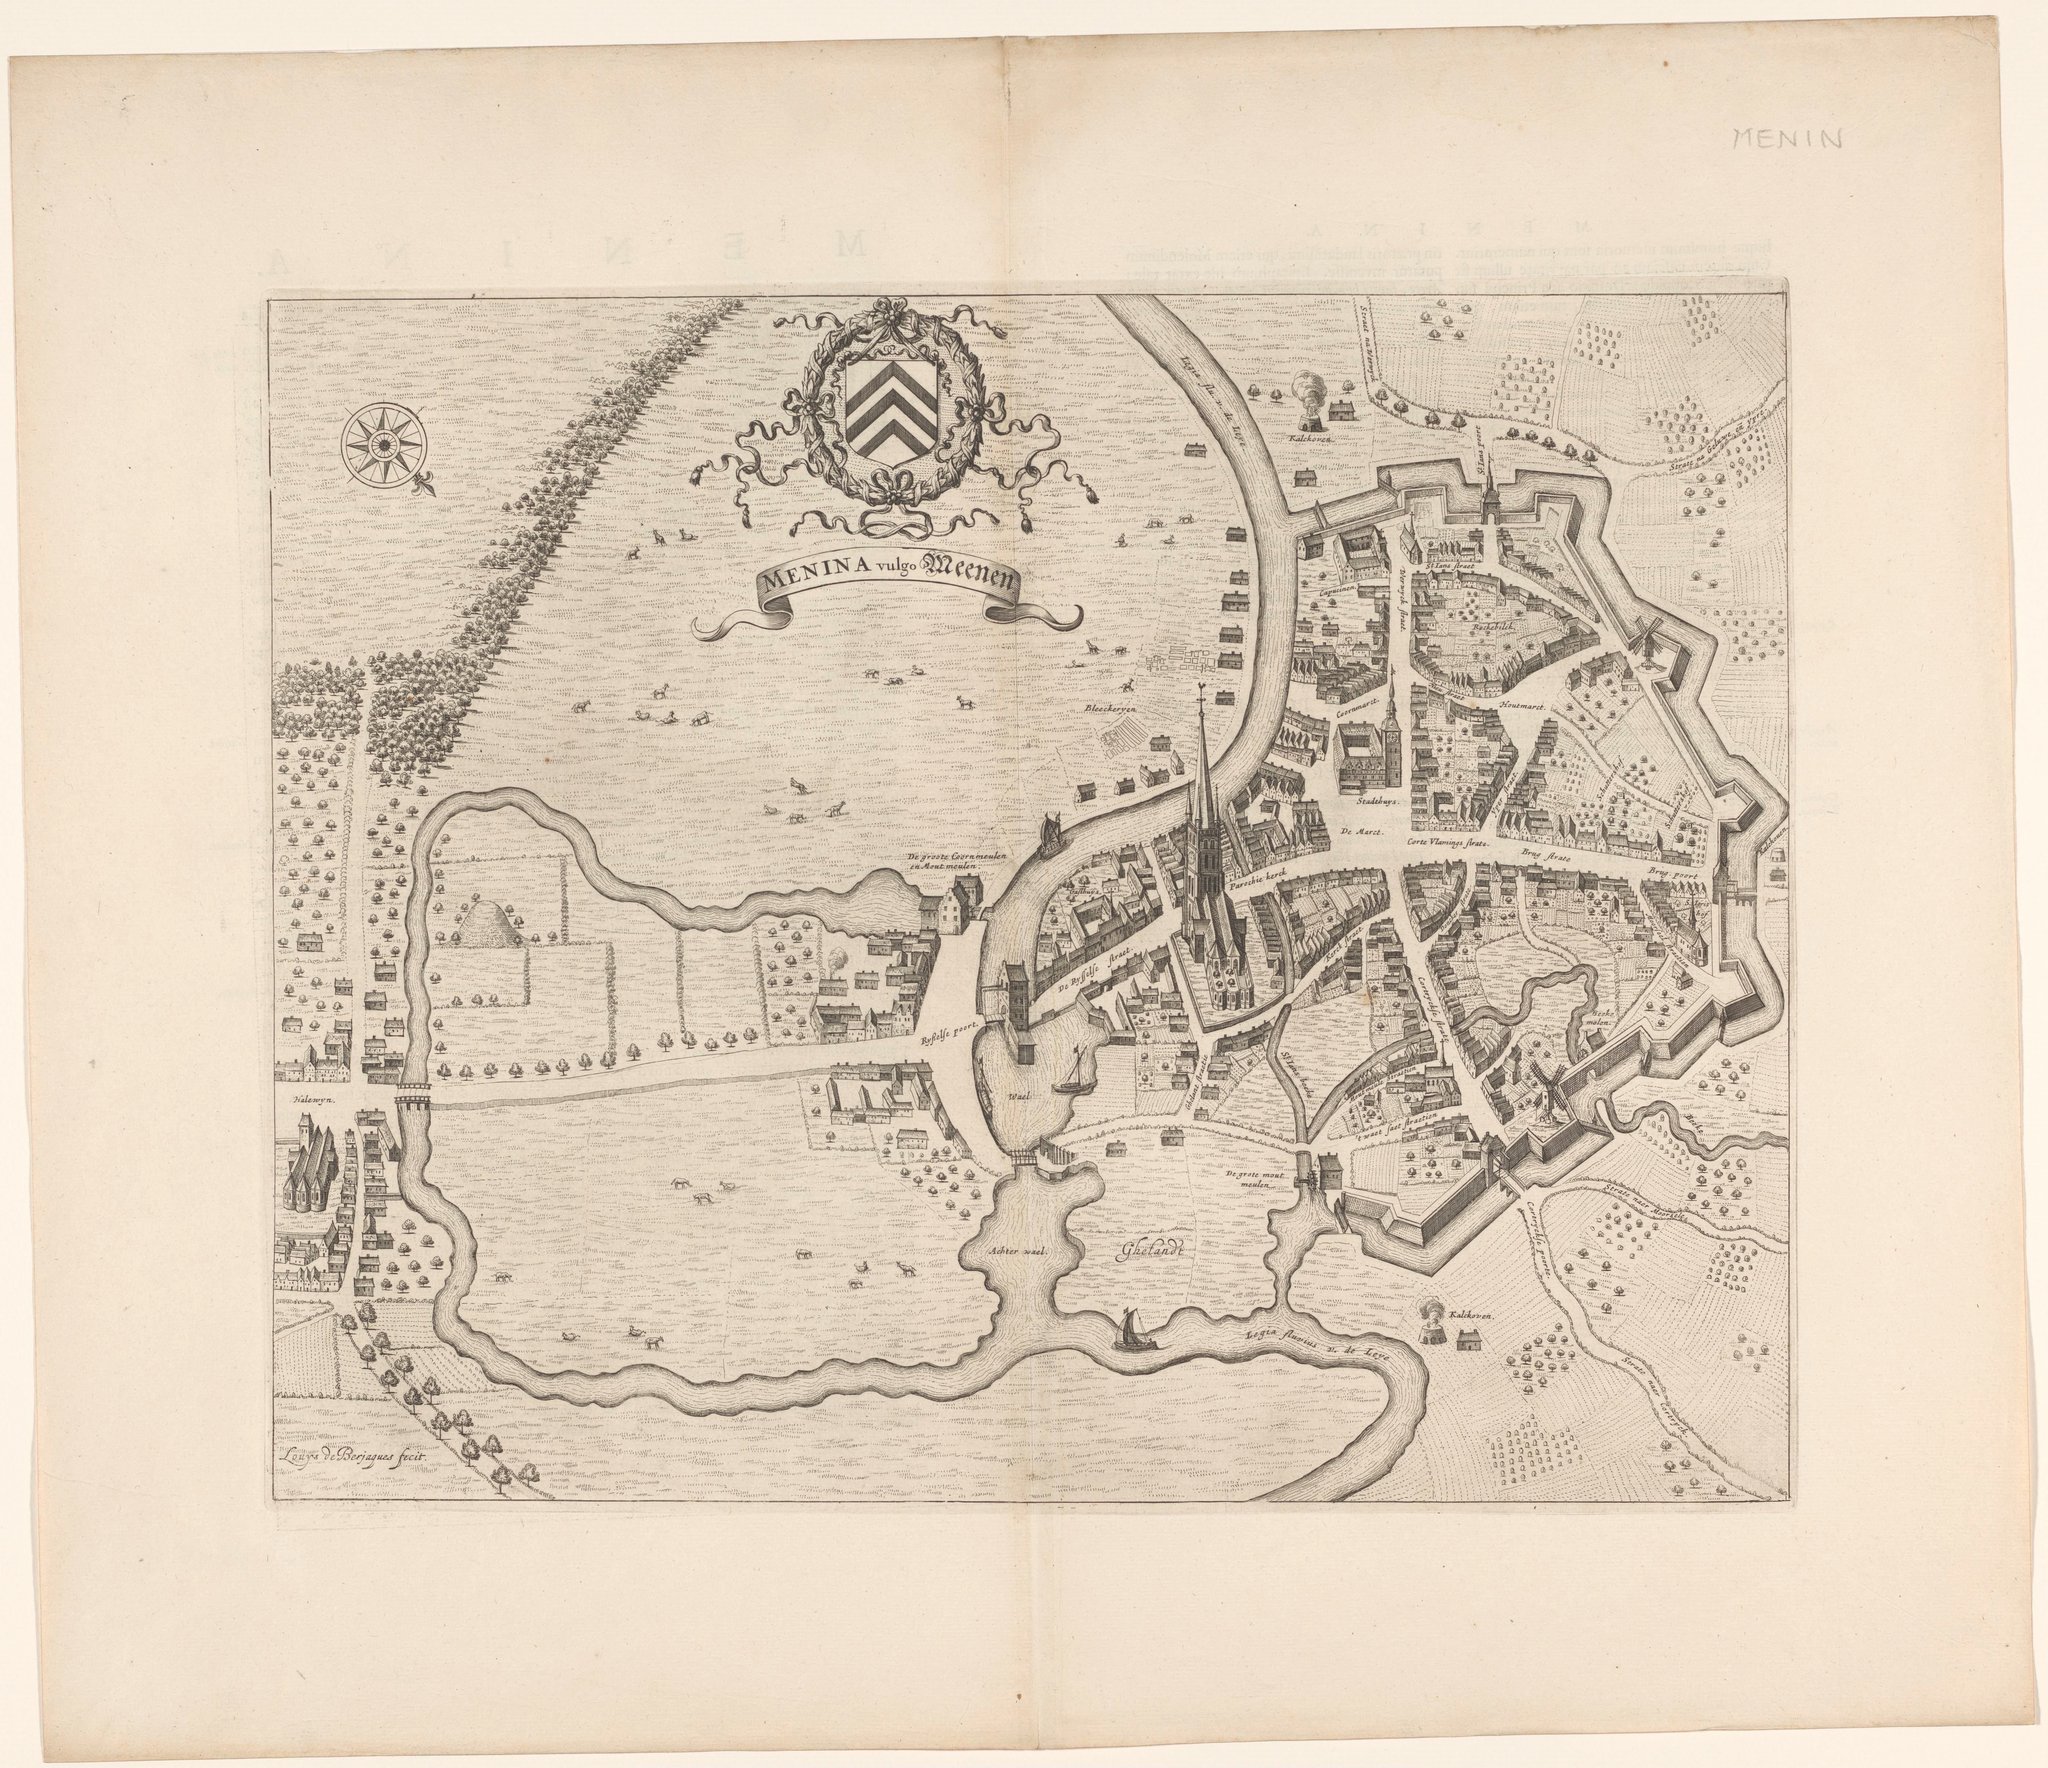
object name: print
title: Plattegrond van Menen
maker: johannes willemszoon blaeu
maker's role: printer, publisher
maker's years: 1596-1673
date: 1652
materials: paper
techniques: engraving, etching, letterpress printing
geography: amsterdam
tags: coat of arms (as symbol of the state, etc.) (+ city; municipal), maps of cities, prospect of city, town panorama, silhouette of city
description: Plattegrond van Menen in vogelvluchtperspectief. Boven, links van het midden, het wapen van Menen met daaronder een banderol met de titel. Met Latijnse tekst op verso.